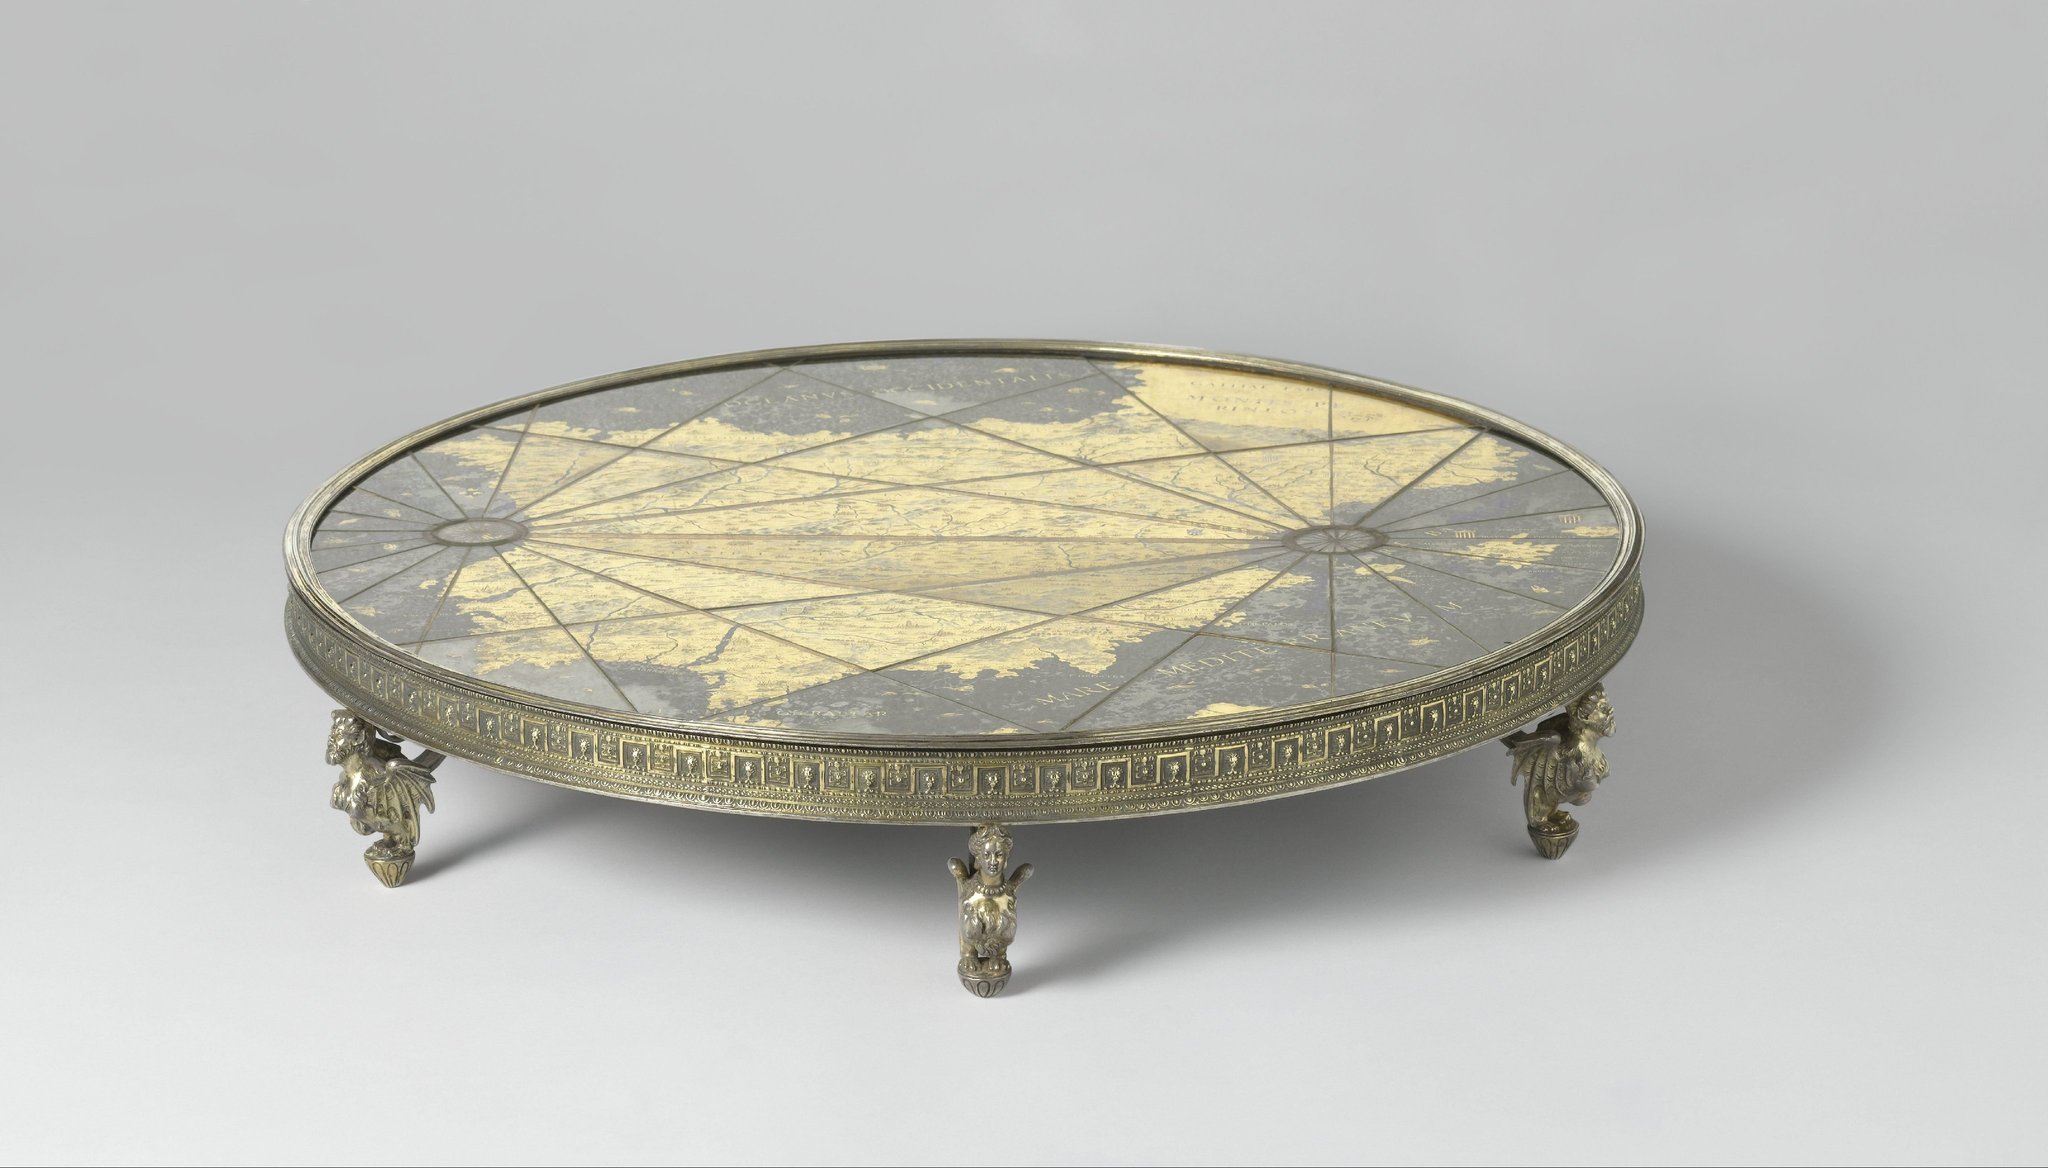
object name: table piece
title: Map of the Iberian Peninsula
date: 1553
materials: brass, bronze, gold, lapis lazuli, silver, stone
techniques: gilding, verre églomisé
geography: nuremberg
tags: maps of separate countries or regions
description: Cartography and art are united here: the map reflects the latest scientific knowledge and the object itself is fashioned from precious materials. Painted on the back of the polished round rock crystal plate is a map of Spain and Portugal. Over the course of time, the original bright blue colour of the expensive lapis lazuli has discoloured almost entirely to a dull grey.